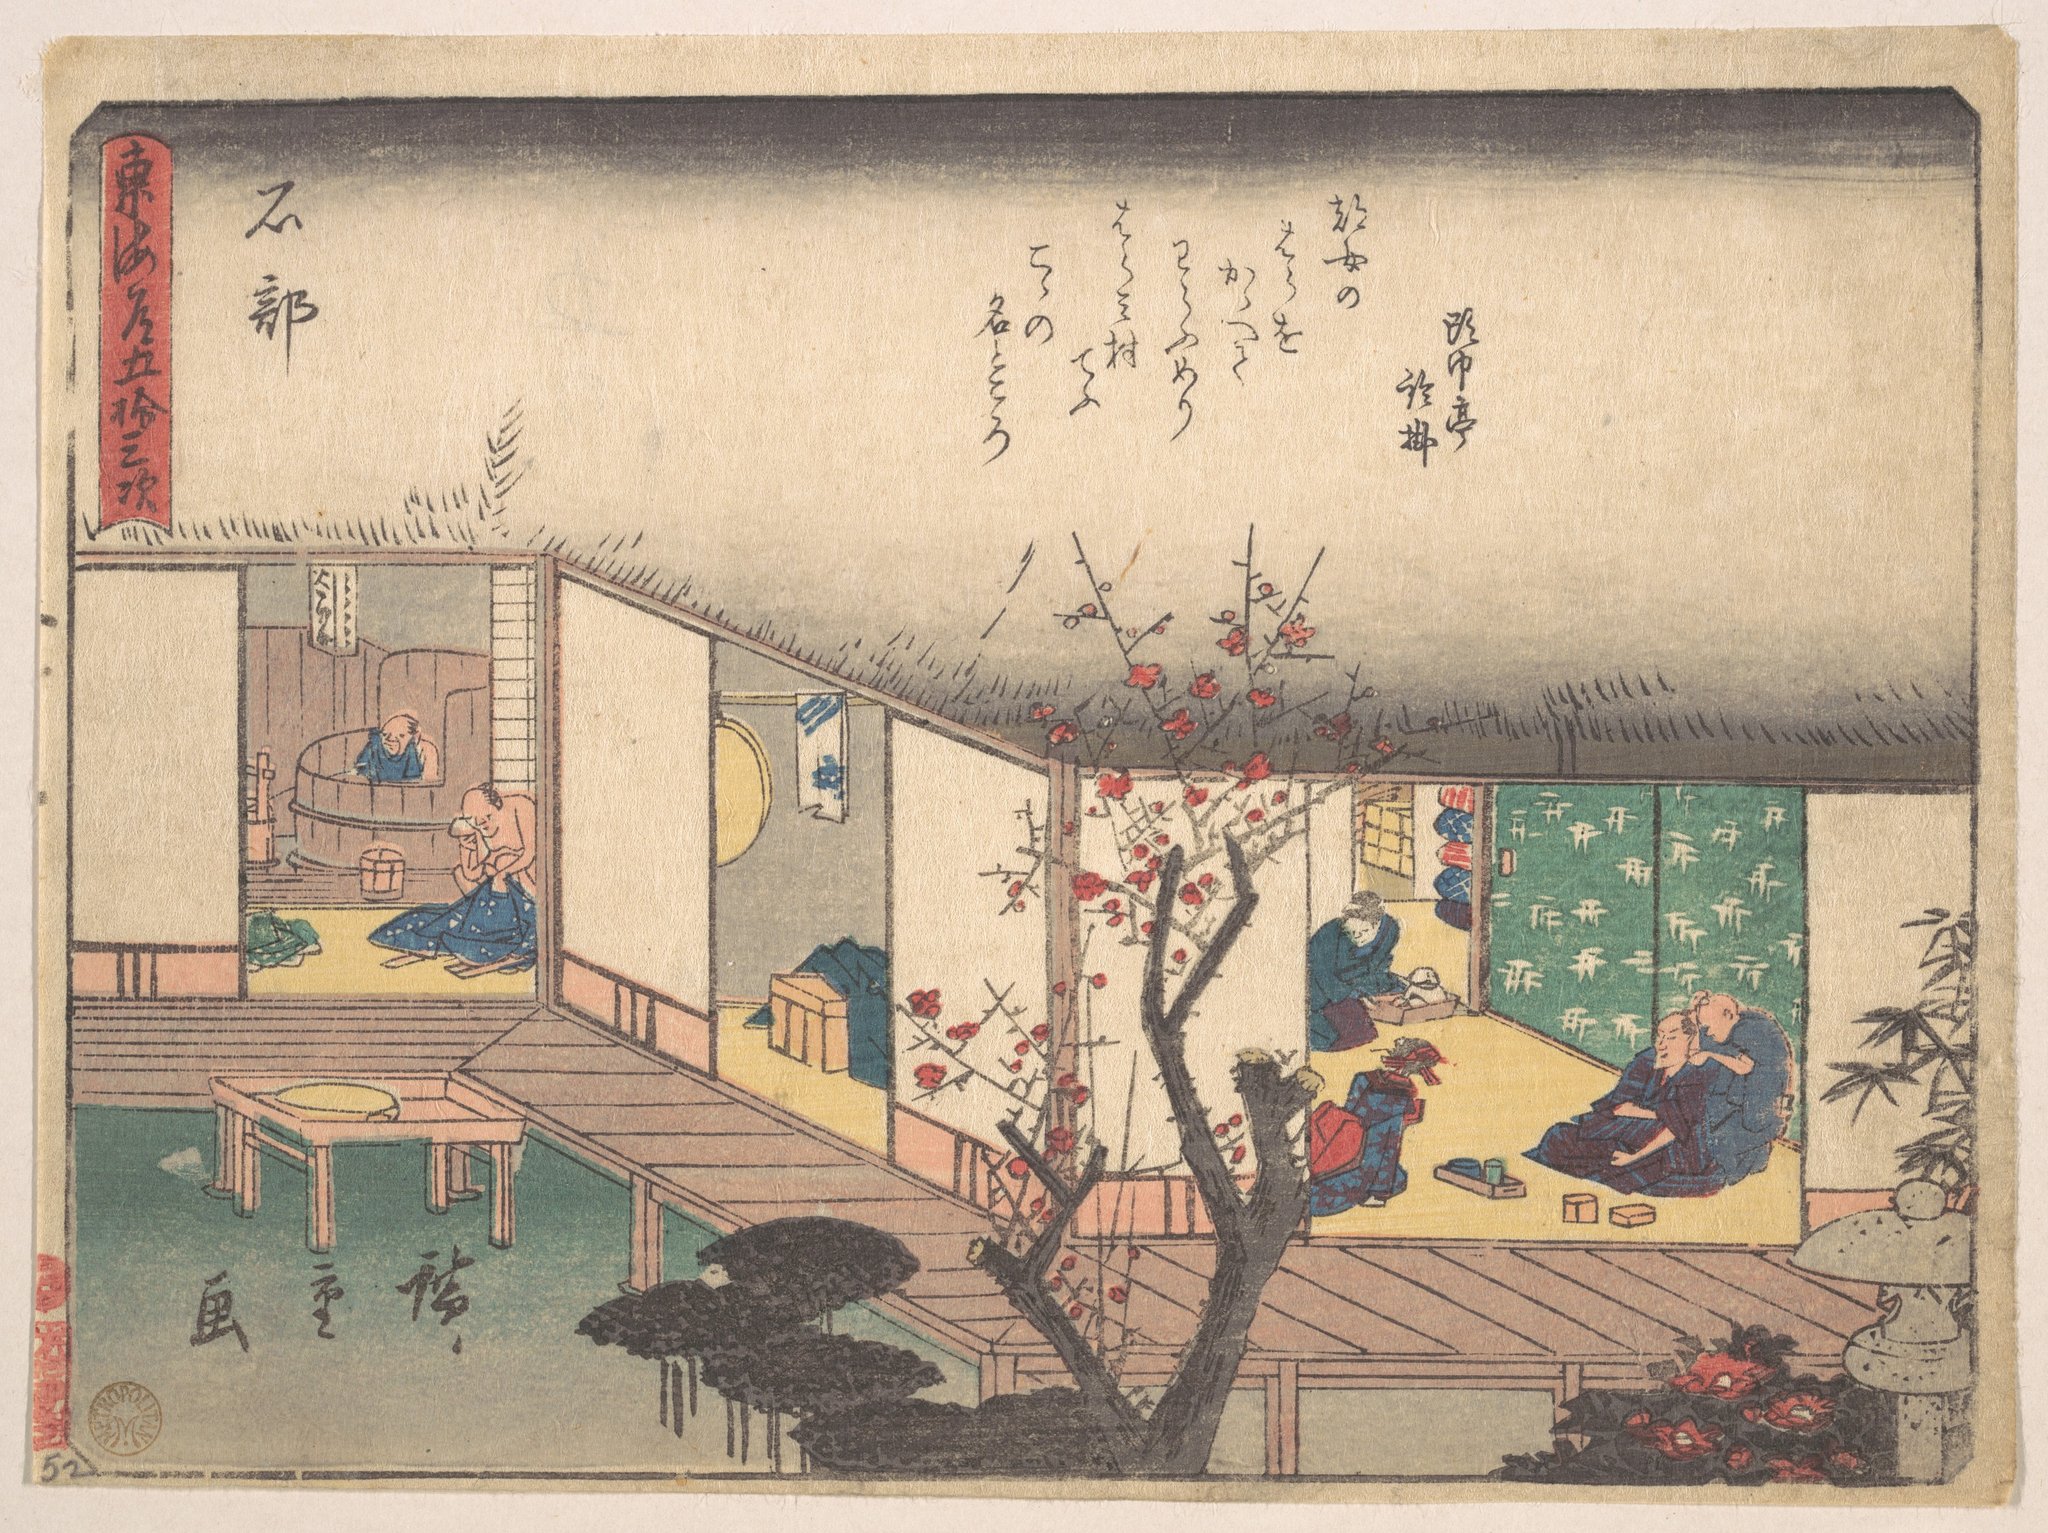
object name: print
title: Ishibe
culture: japanese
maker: utagawa hiroshige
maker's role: artist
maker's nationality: japanese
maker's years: 1797-1858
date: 1838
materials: ink, paper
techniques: woodblock print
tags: human figures,trees